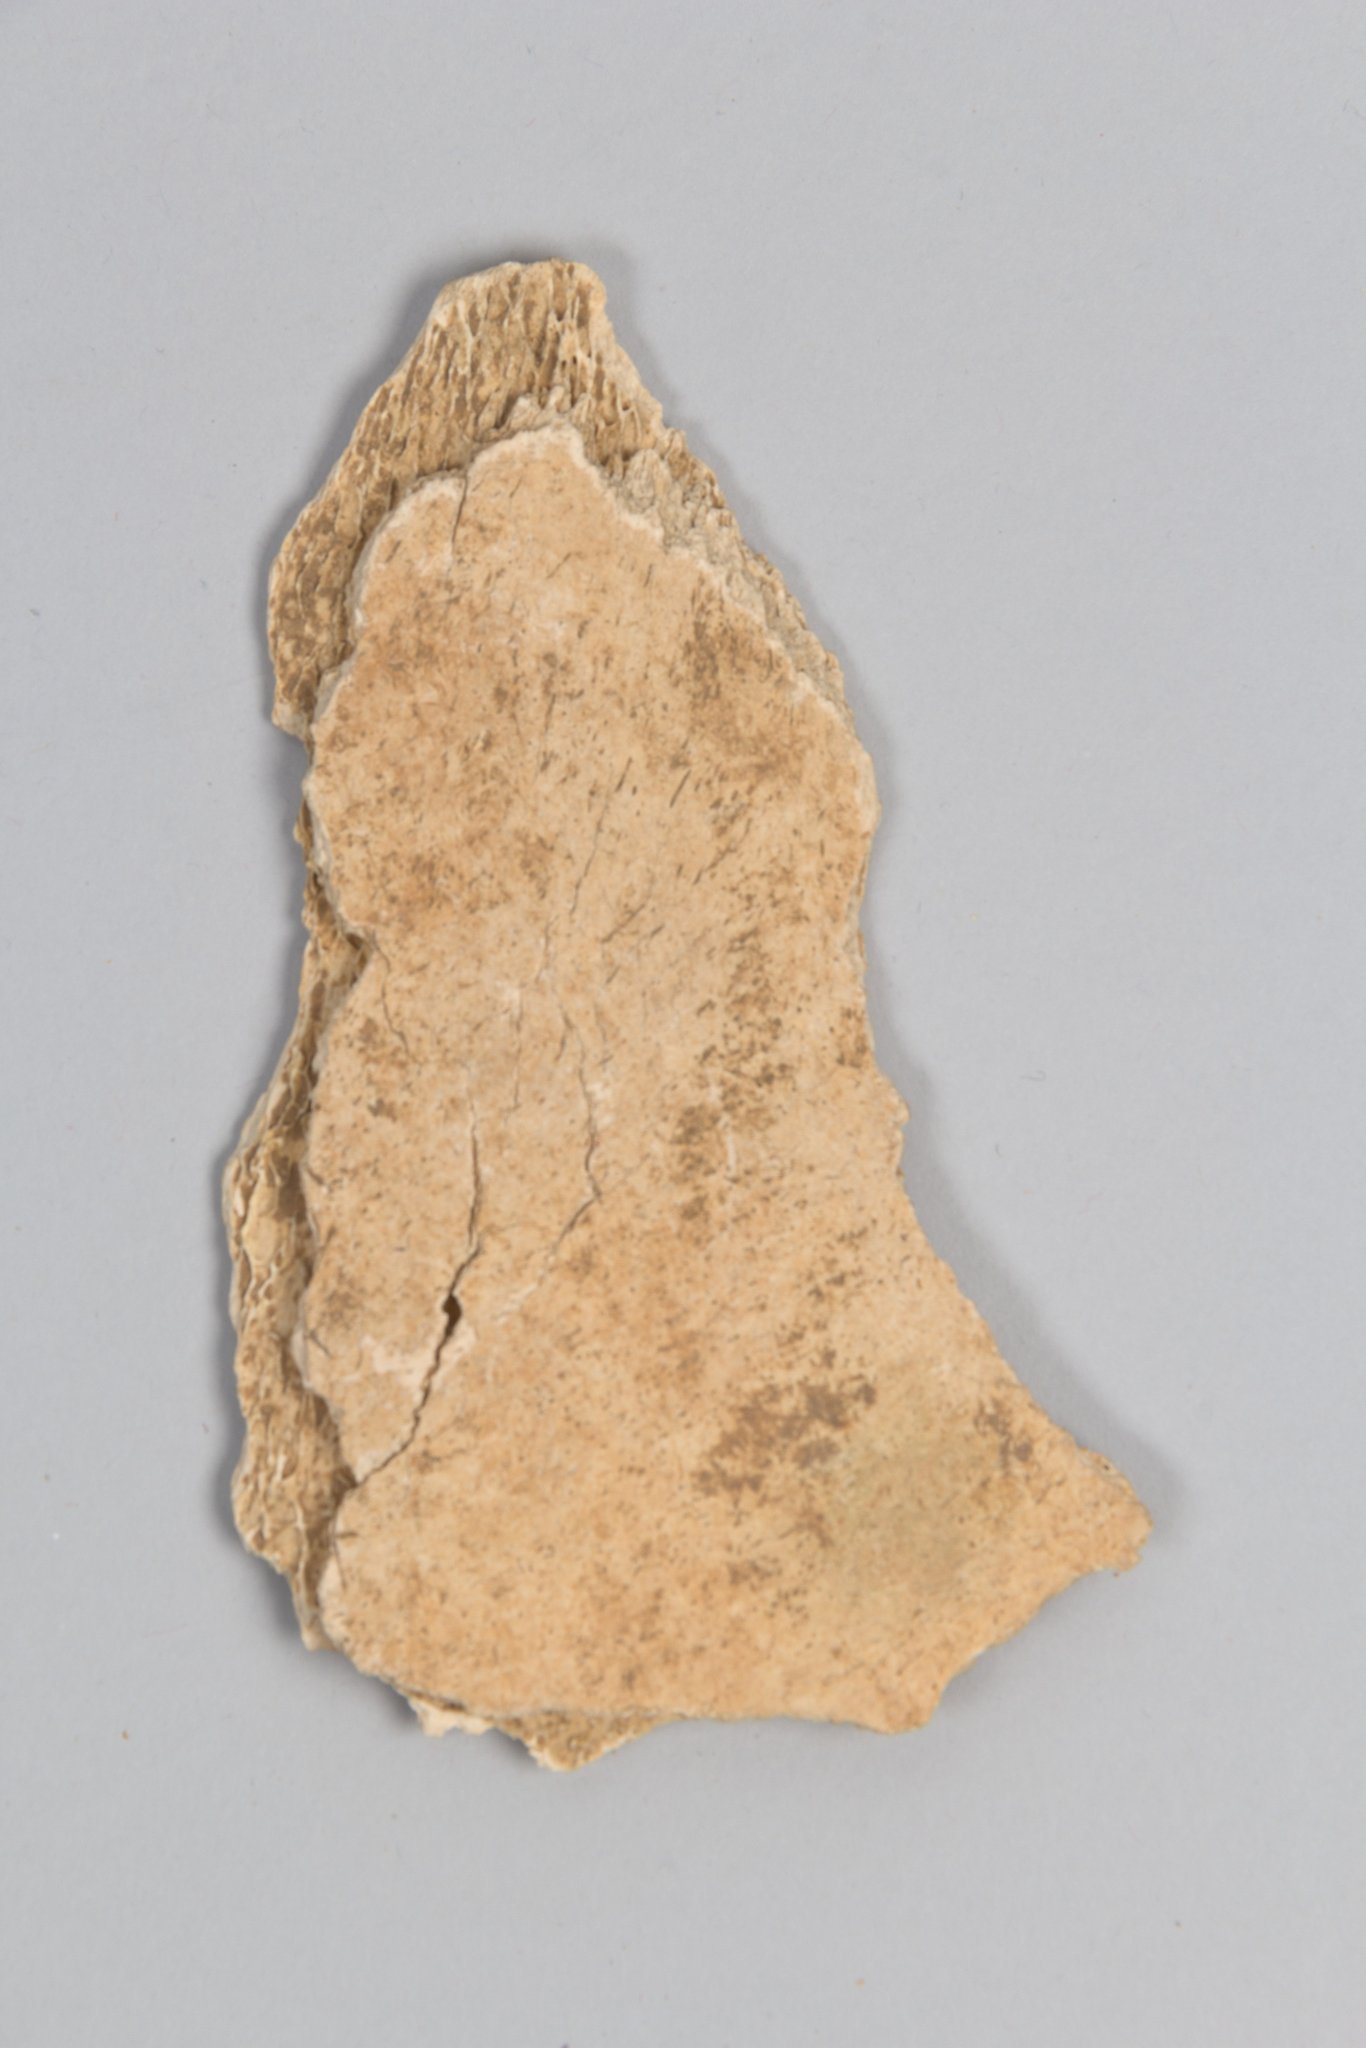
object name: oracle bone fragment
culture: chinese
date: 1610-1036 BCE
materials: bone